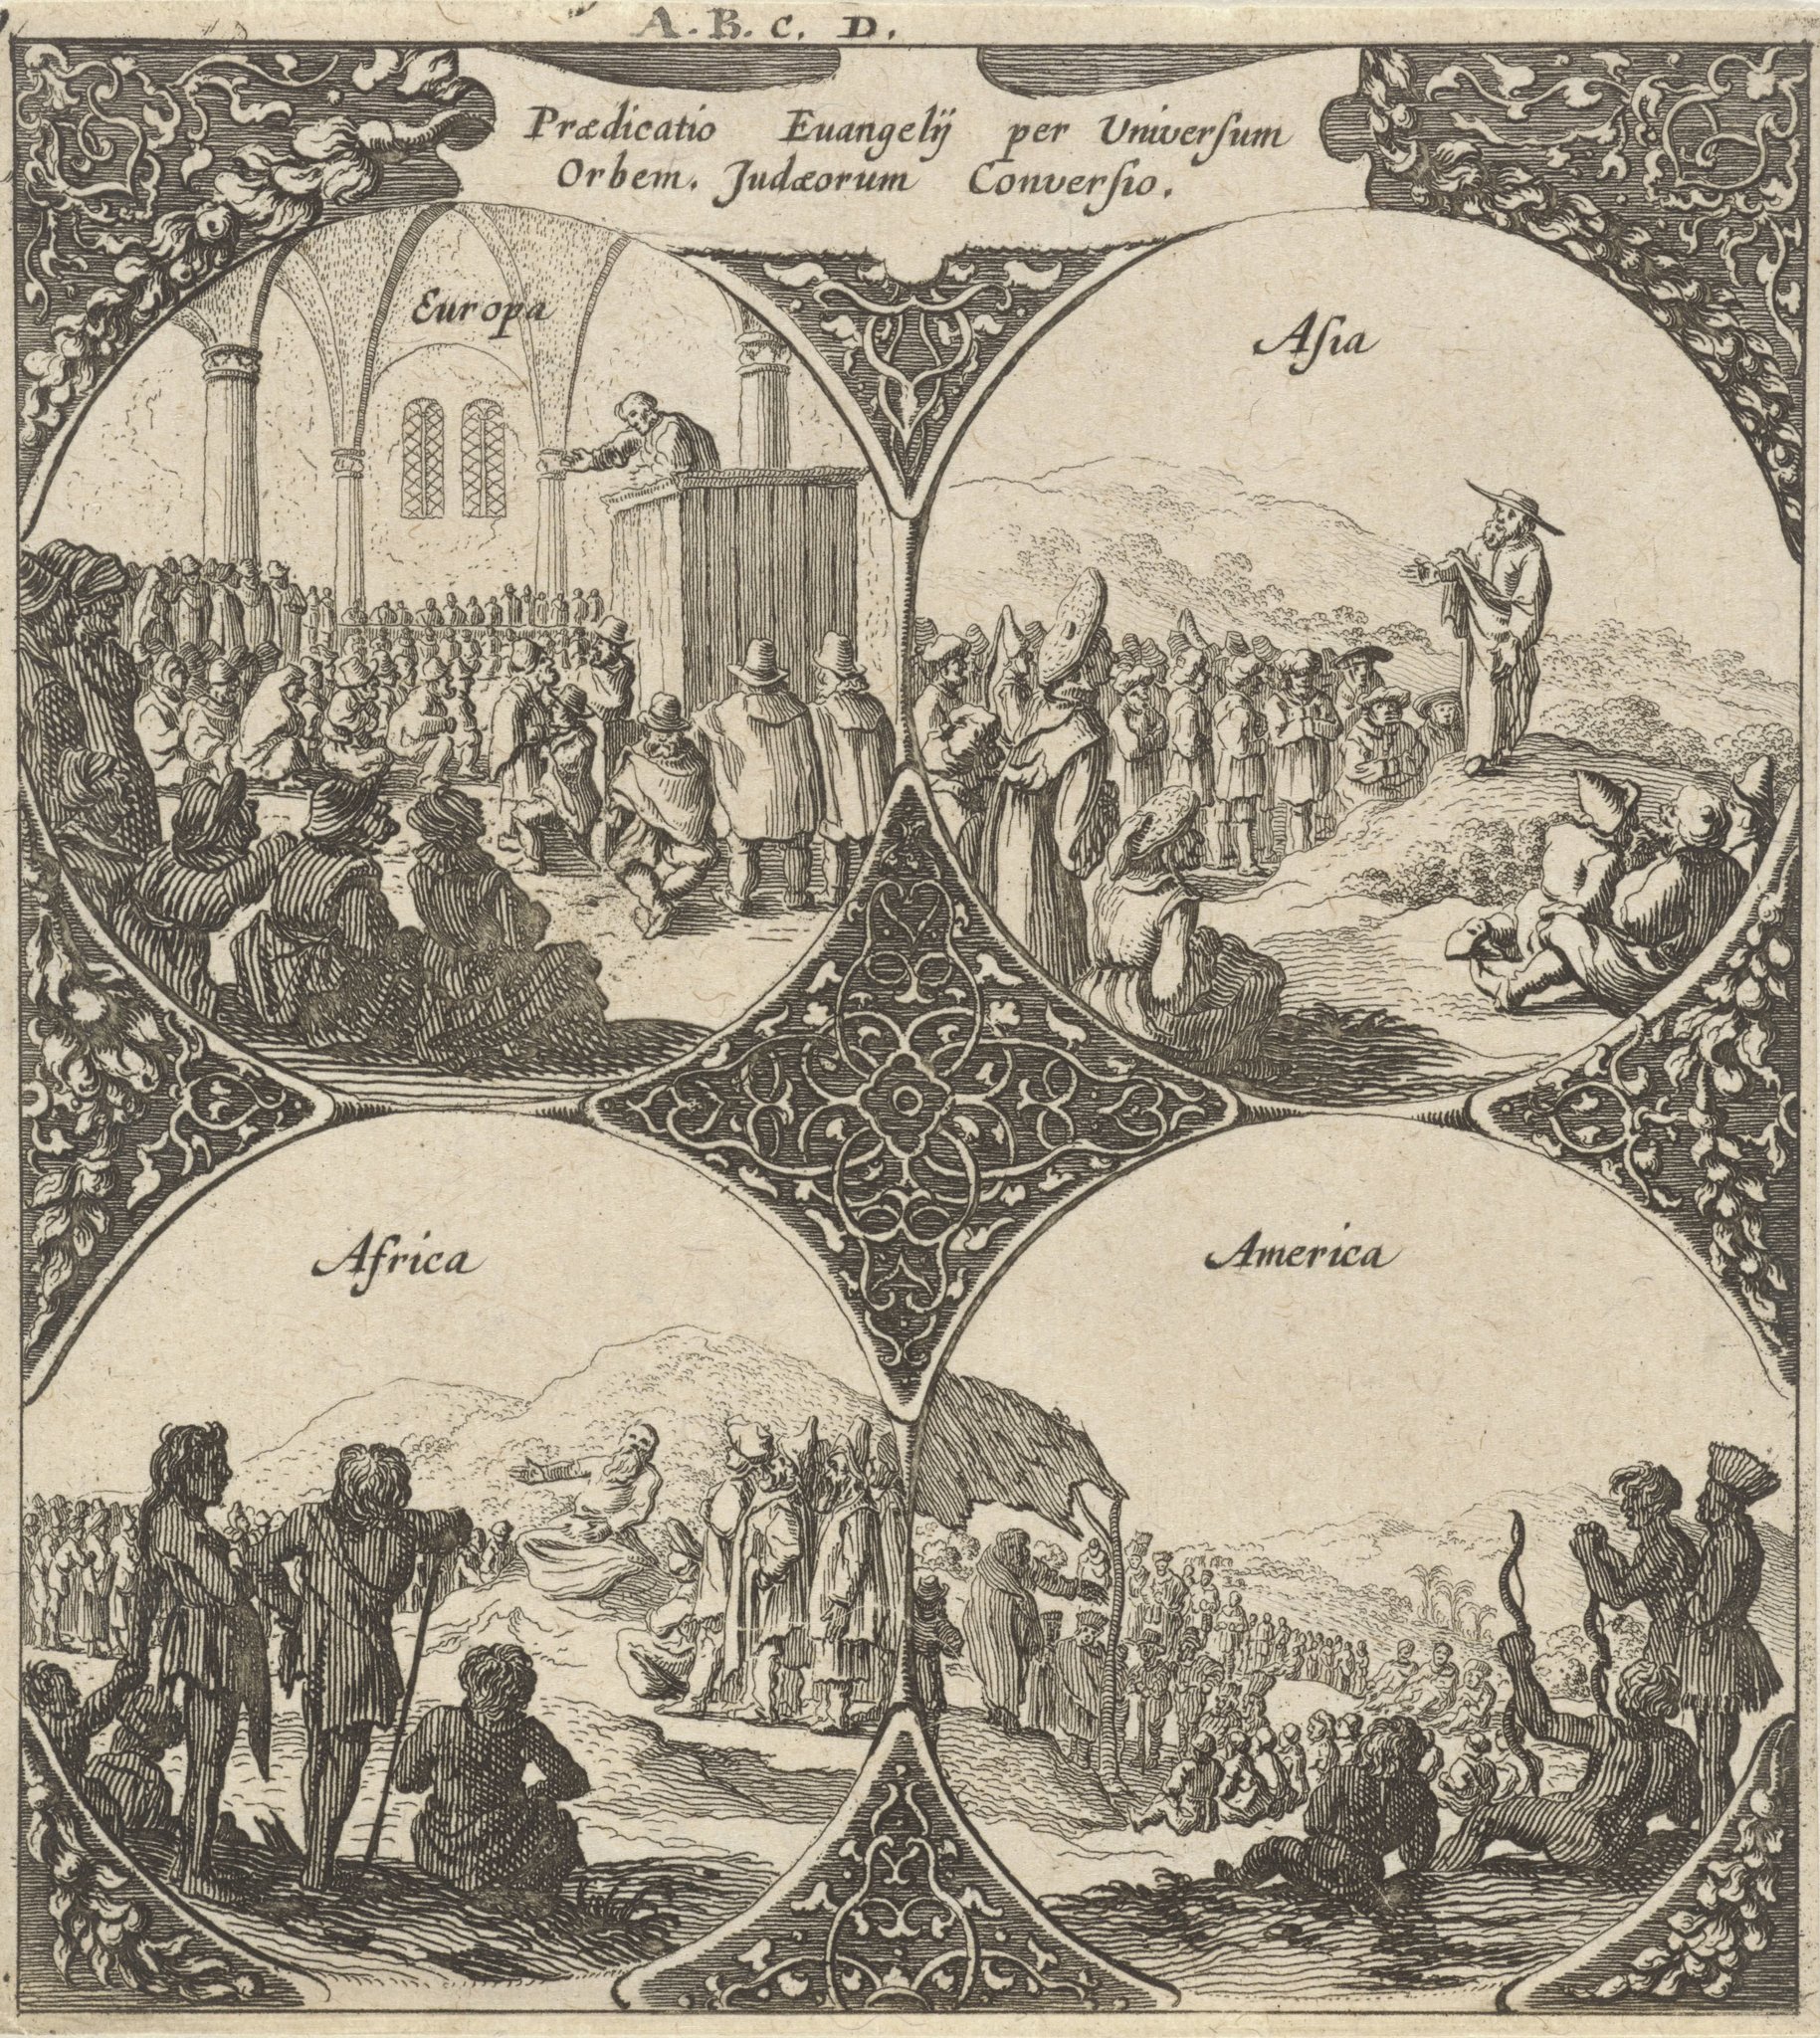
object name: book illustration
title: Predikanten in vier werelddelen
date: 1625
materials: paper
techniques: etching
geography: cleves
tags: (map of) asia, (map of) africa, preaching (in general), (map of) europe, (map of) america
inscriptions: collector's mark: Lugt 2228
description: Illustratie in: Peil, Johann. Tabula processum seu ordinem ultimi divini et criminalis judicii exhibens. Kleef: Gerhardus Verstegen, 1625, p. 8.